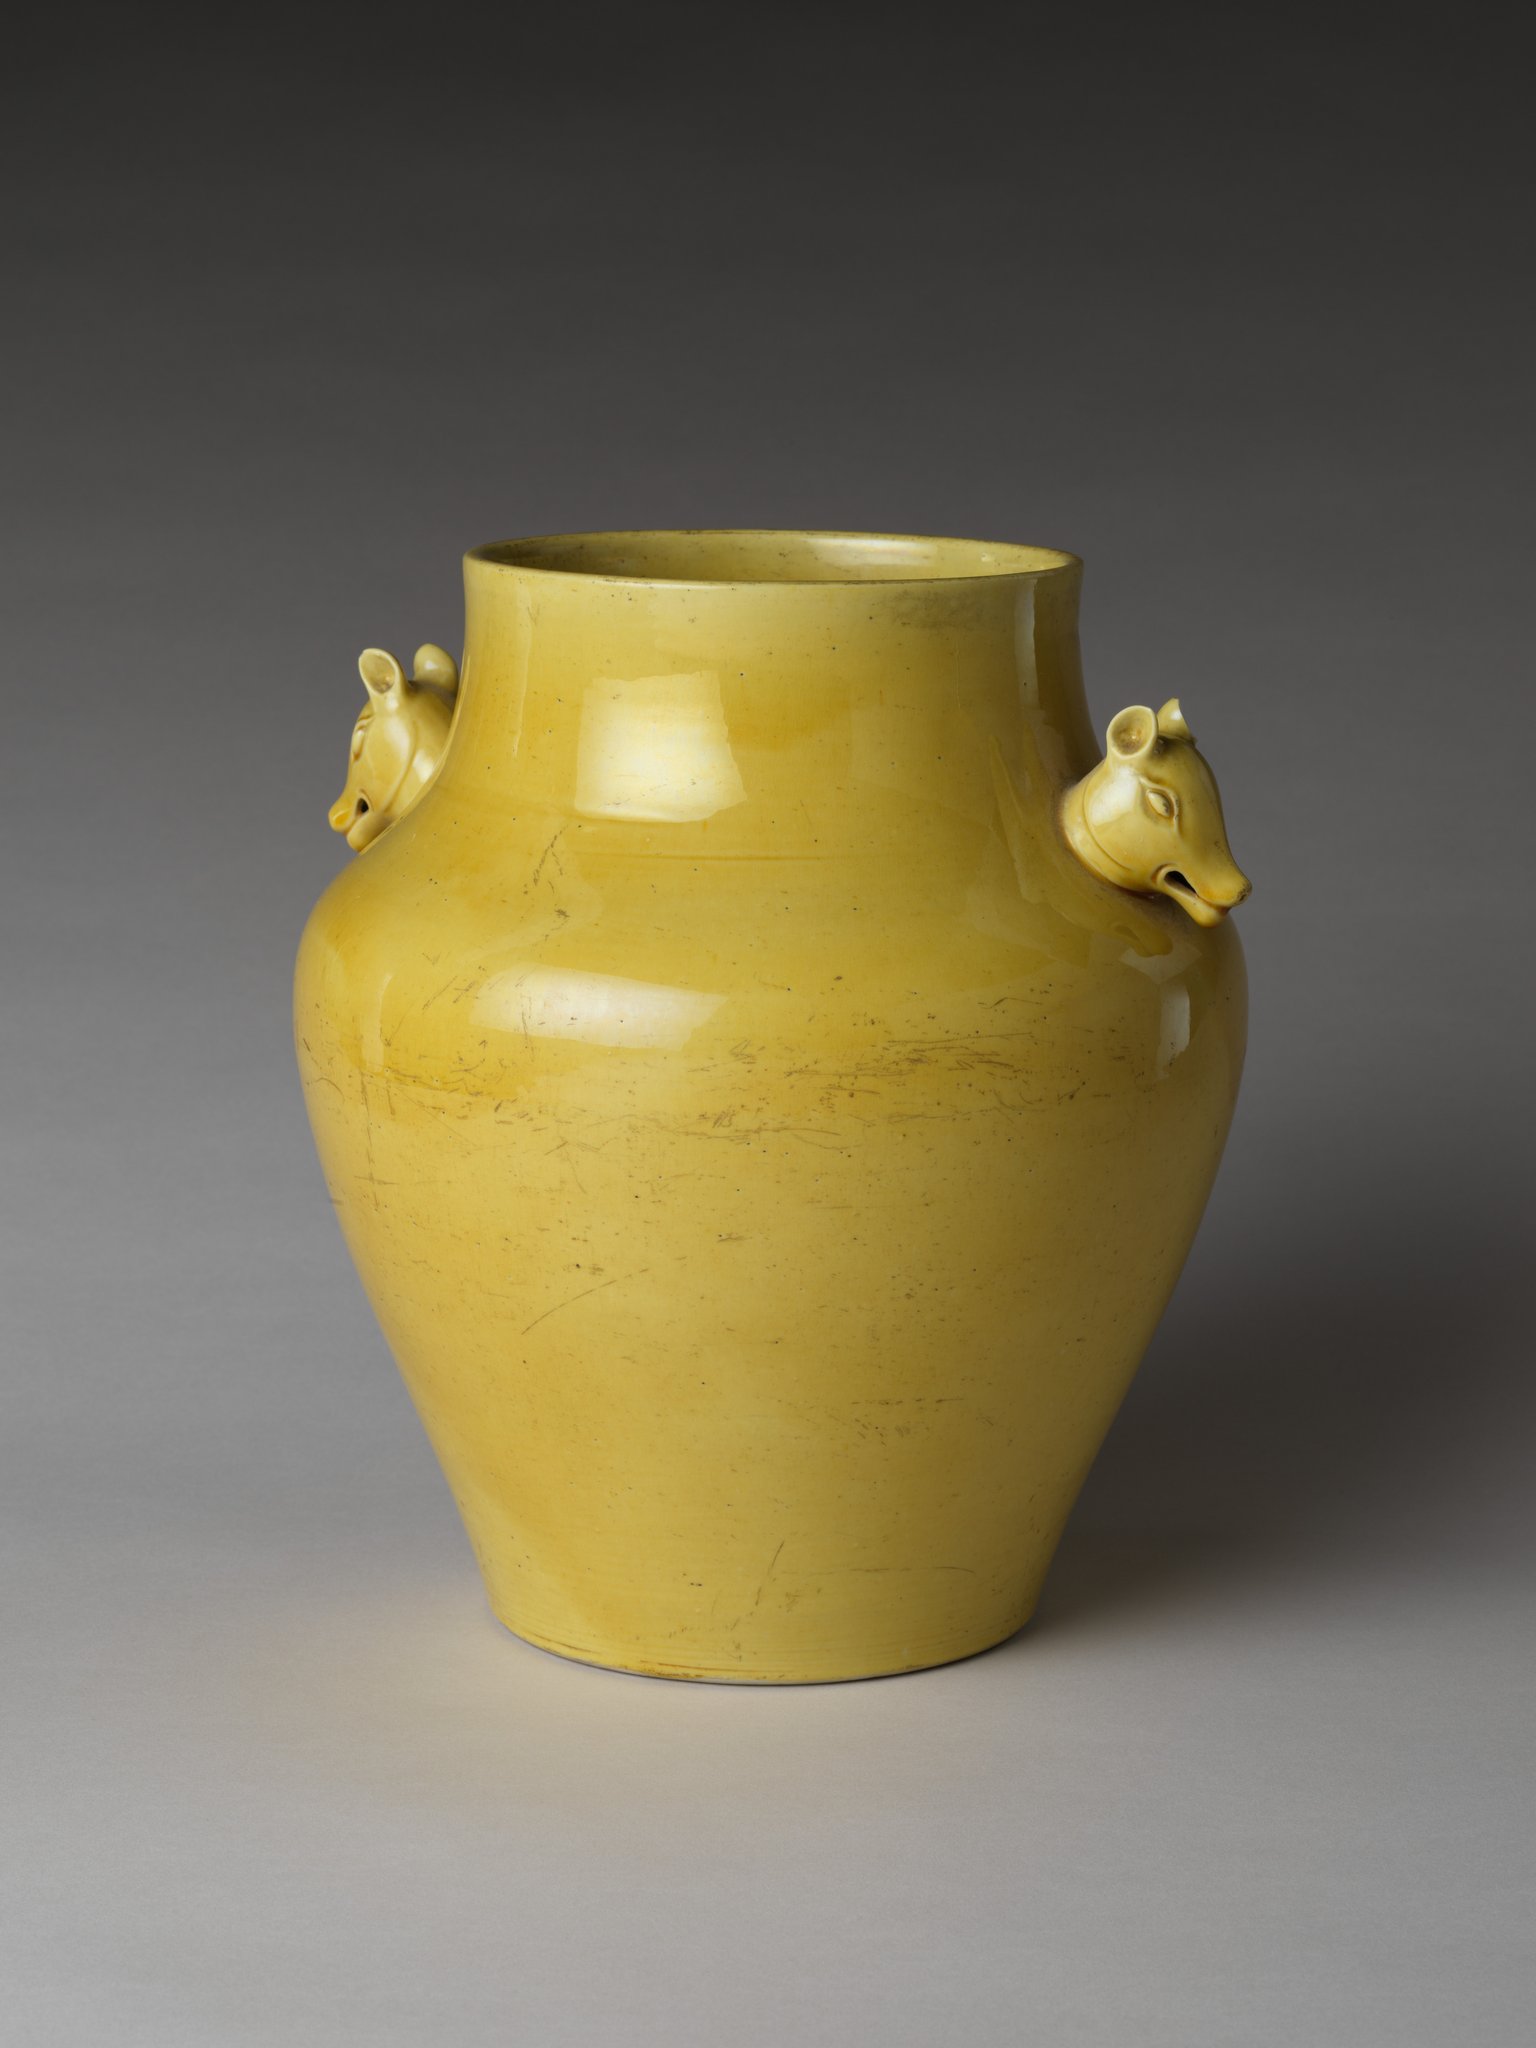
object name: vessel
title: Ceremonial vessel with animal heads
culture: chinese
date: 1701-1800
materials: glaze, porcelain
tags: animals